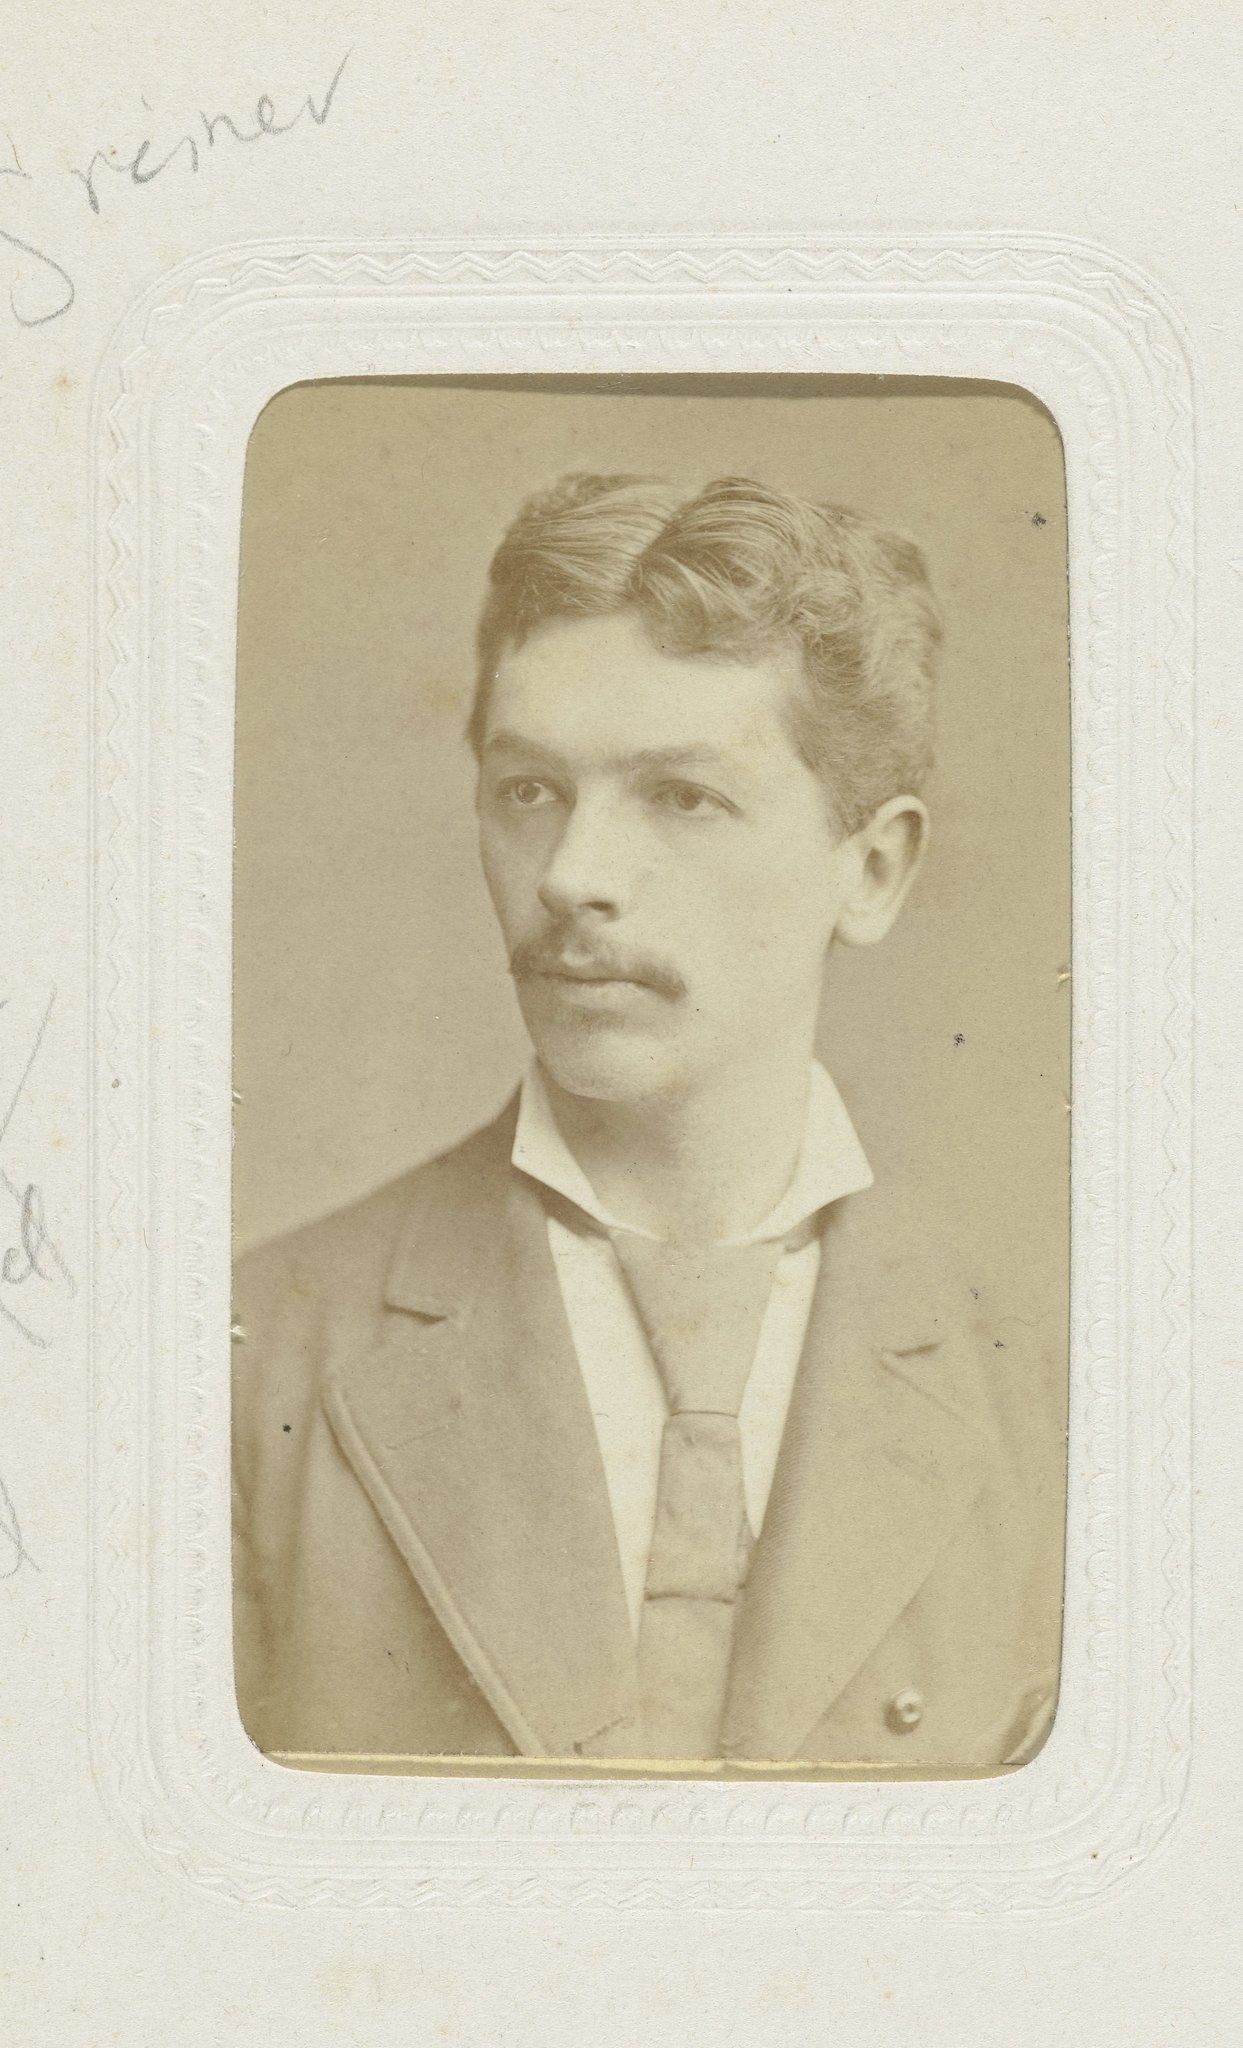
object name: carte de visite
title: Studioportret van een man met een snor en stropdas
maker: albert greiner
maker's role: fotograaf, fotostudio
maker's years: 1833-1890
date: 1863-1866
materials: cardboard, paper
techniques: albumen print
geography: amsterdam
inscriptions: name: ‘Albert Greiner, Amsterdam’